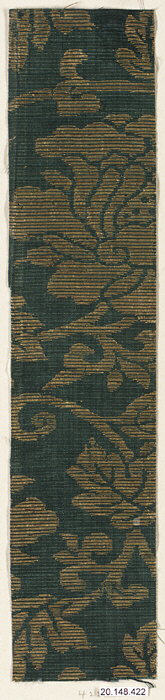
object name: piece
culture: japanese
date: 1701-1800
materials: silk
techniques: compound weave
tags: flowers,leaves